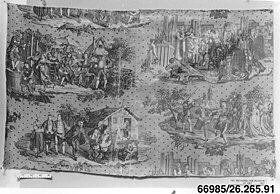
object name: furnishing textile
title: The Rustic Wedding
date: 1820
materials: cotton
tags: human figures,houses,trees